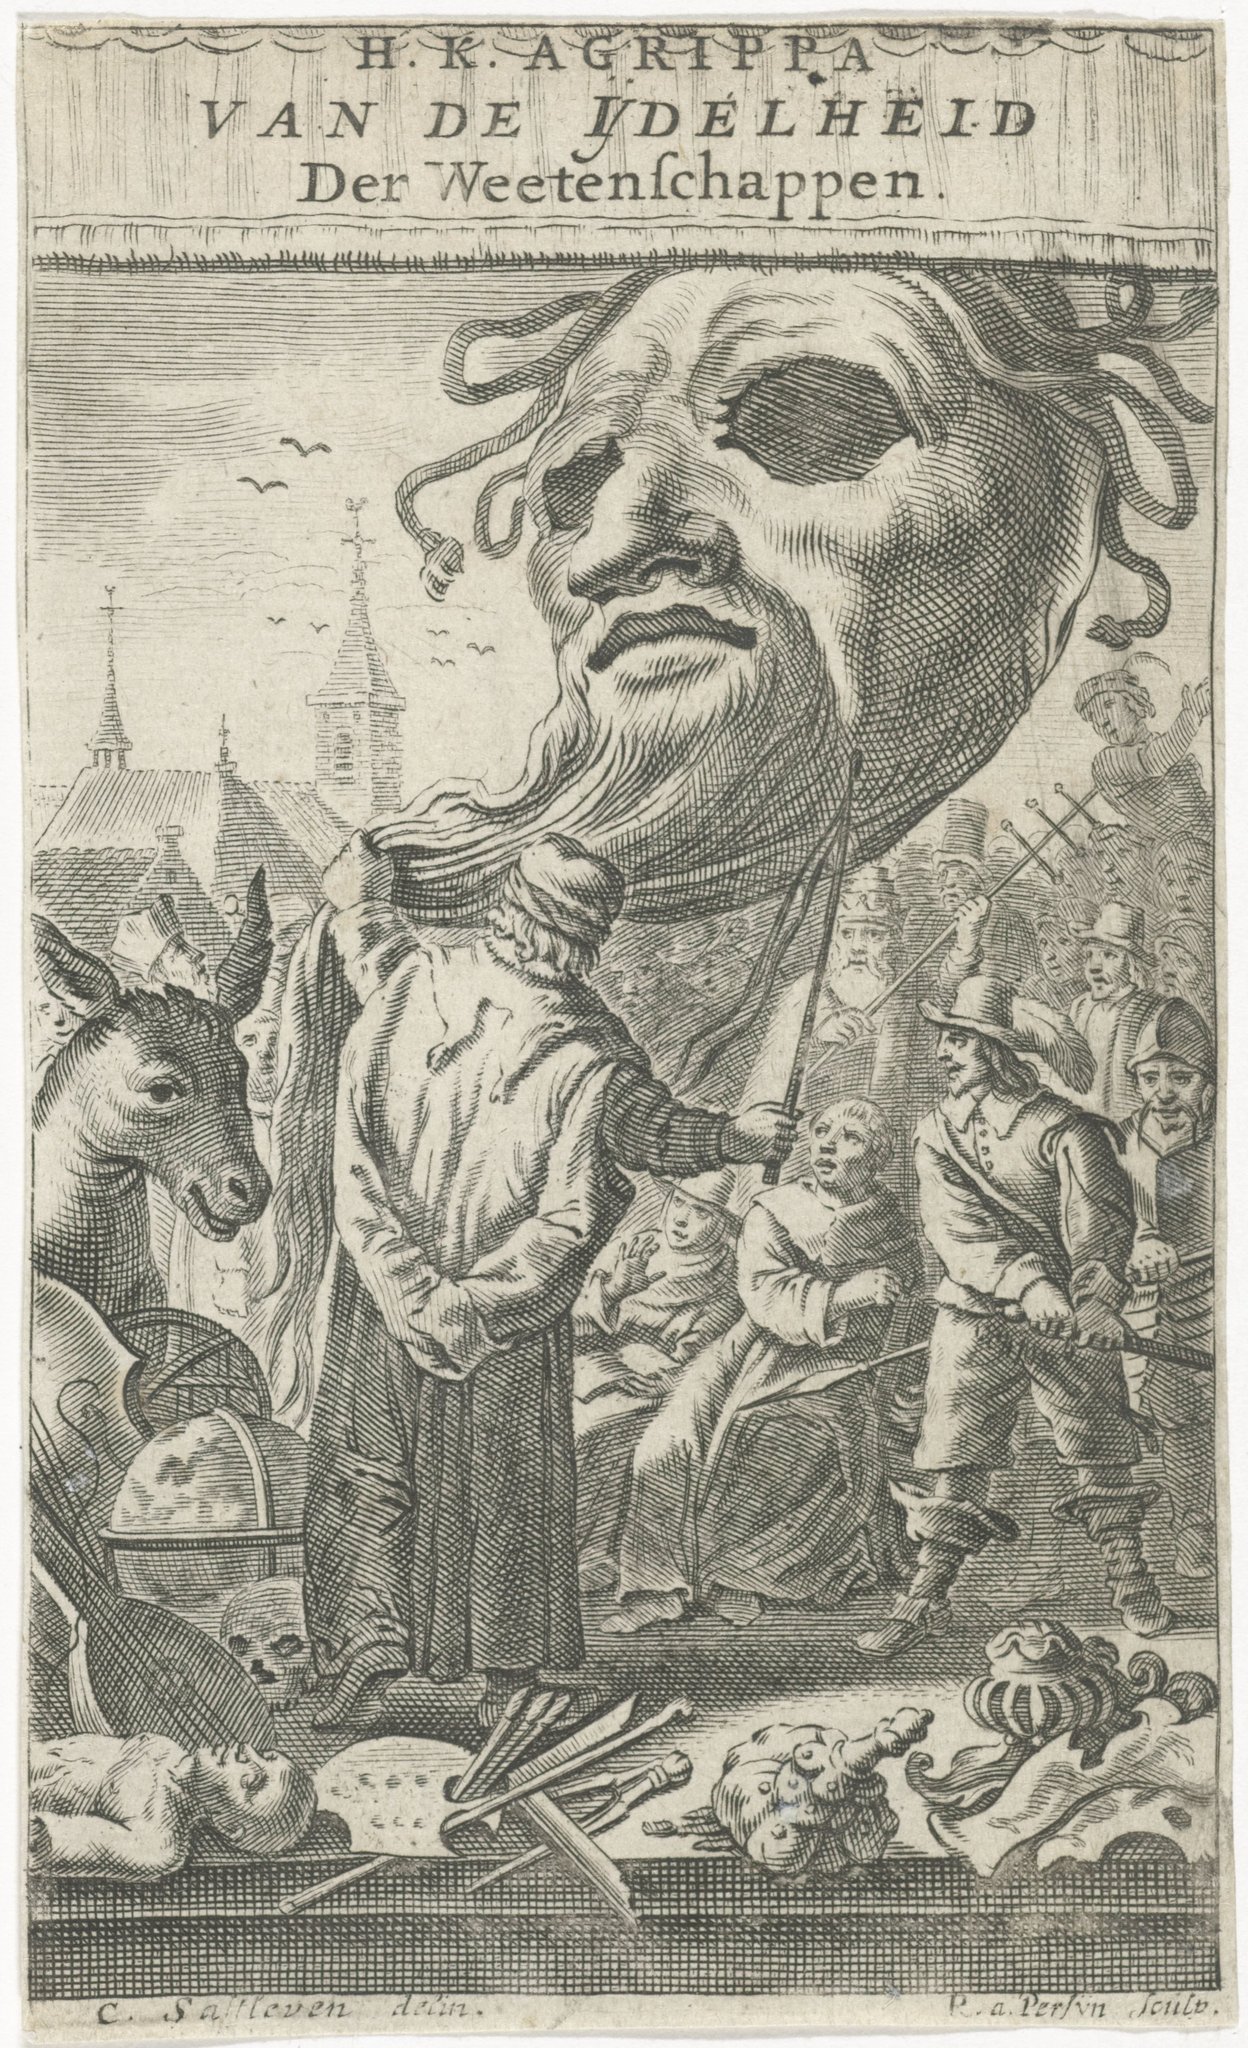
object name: print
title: Titelpagina voor: J. Oudaen, Agrippa, van de ijdelheid der wetenschappen, 1661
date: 1661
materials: paper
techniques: engraving, letterpress printing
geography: rotterdam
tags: skull as symbol of 'vanitas', folly, foolishness; 'pazzia', 'sciocchezza', 'stoltitia' (ripa), symbolic representations, allegories and emblems ~ art; 'arte' (ripa)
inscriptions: collector's mark: Lugt 2228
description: Spotprent op de kunsten: een markplein met een man die een groot zwevend masker vasthoudt. Hij wordt omringd door mensen van diverse pluimage. Omstanders kijken vol ontzag naar het tafereel. Op de voorgrond attributen die de kunsten symboliseren, een ezel en een schedel, die verwijzen naar domheid en vergankelijkheid. In het kader boven de voorstelling de titel in het Nederlands in boekdruk.